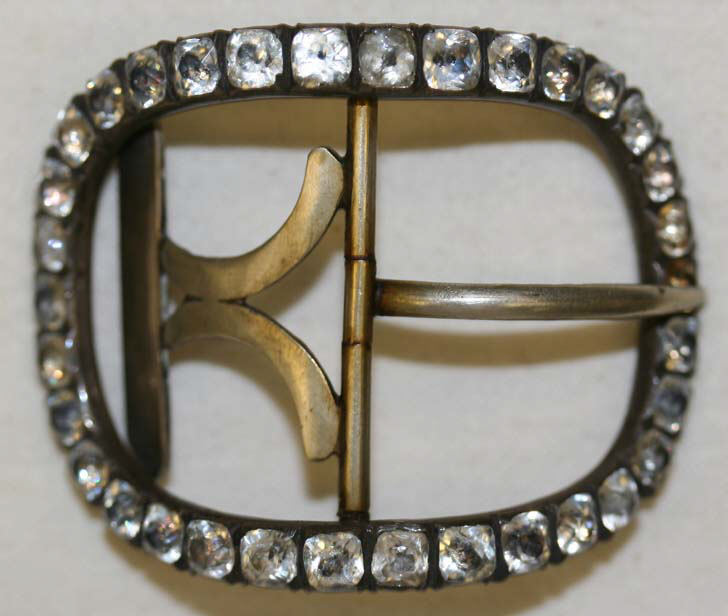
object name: shoe buckle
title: Shoe buckles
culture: british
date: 1767-1800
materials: metal, paste